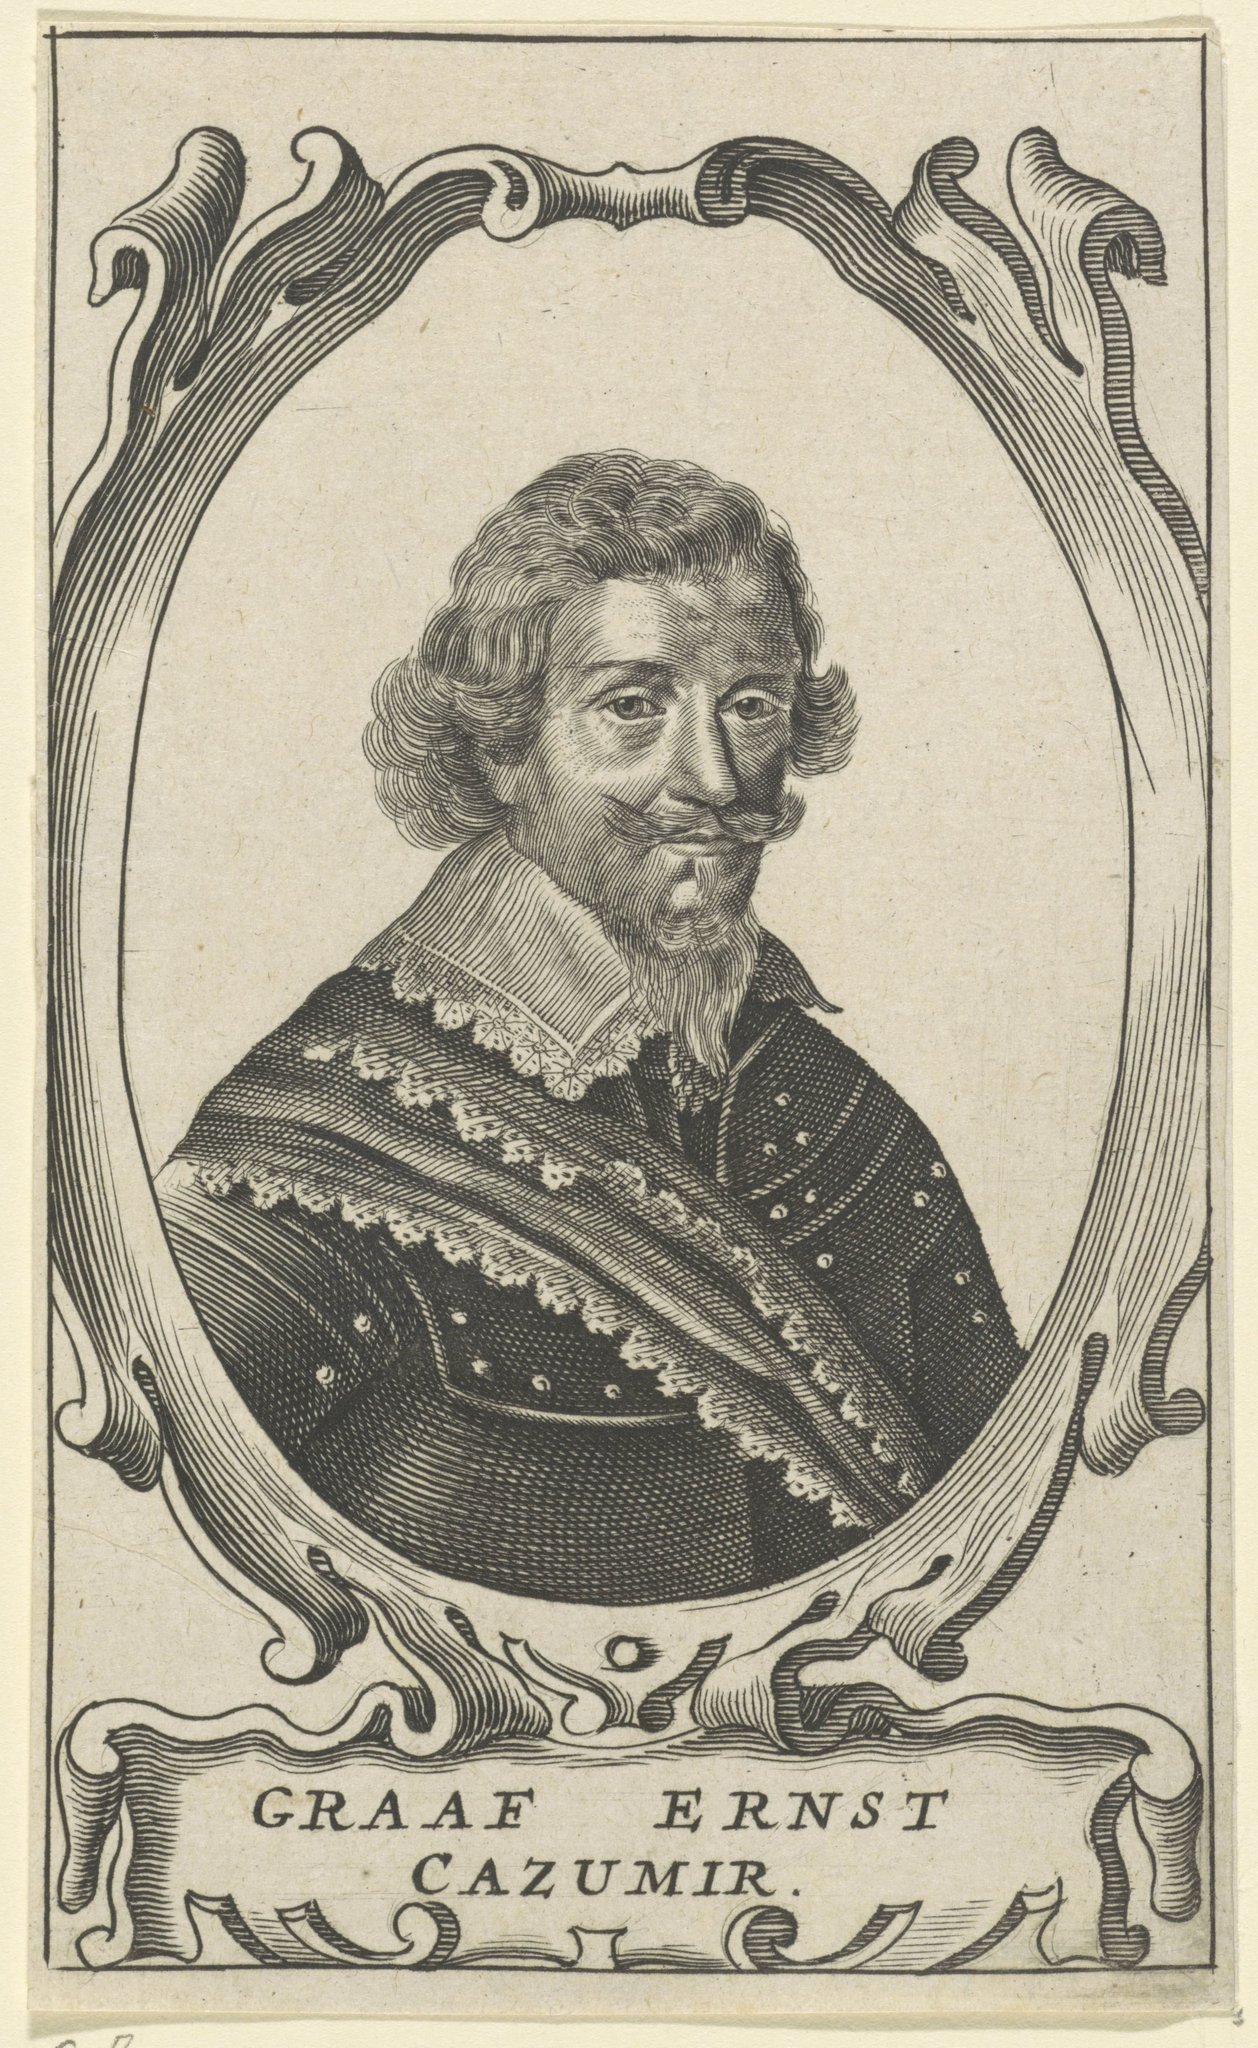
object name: print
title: Portret van Ernst Casimir, graaf van Nassau-Dietz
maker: Anonymous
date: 1600-1699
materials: paper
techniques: engraving, etching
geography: low countries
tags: ernst casimir graaf van nassau-dietz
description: De hier vermelde titel verwijst naar de hoogst verkregen titel van de geportretteerde, niet per se naar de titel die de geportretteerde op deze voorstelling draagt.